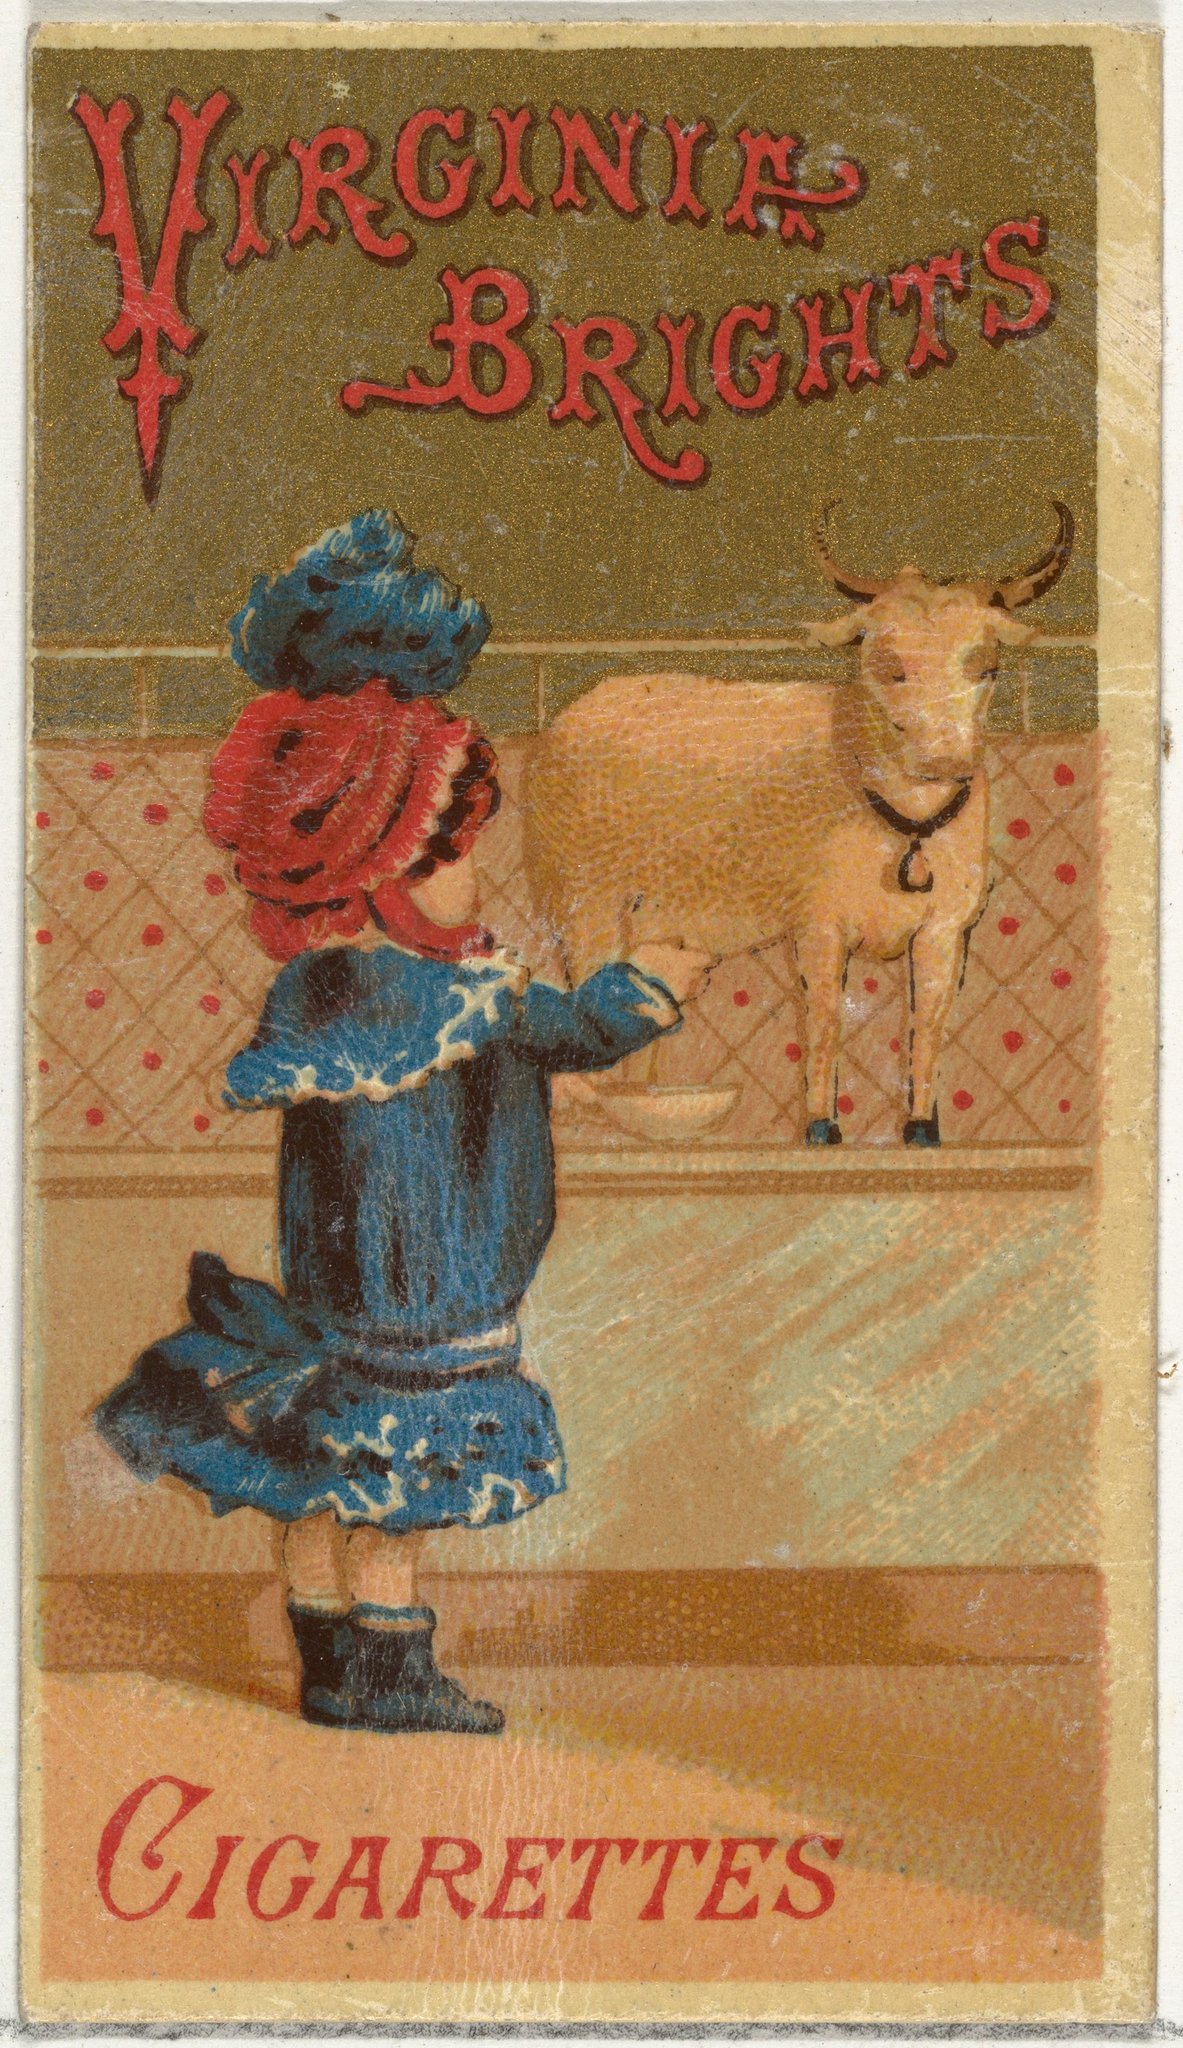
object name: print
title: From the Girls and Children series (N64) promoting Virginia Brights Cigarettes for Allen & Ginter brand tobacco products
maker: allen & ginter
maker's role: publisher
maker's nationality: american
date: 1886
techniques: color lithograph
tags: girls,cows